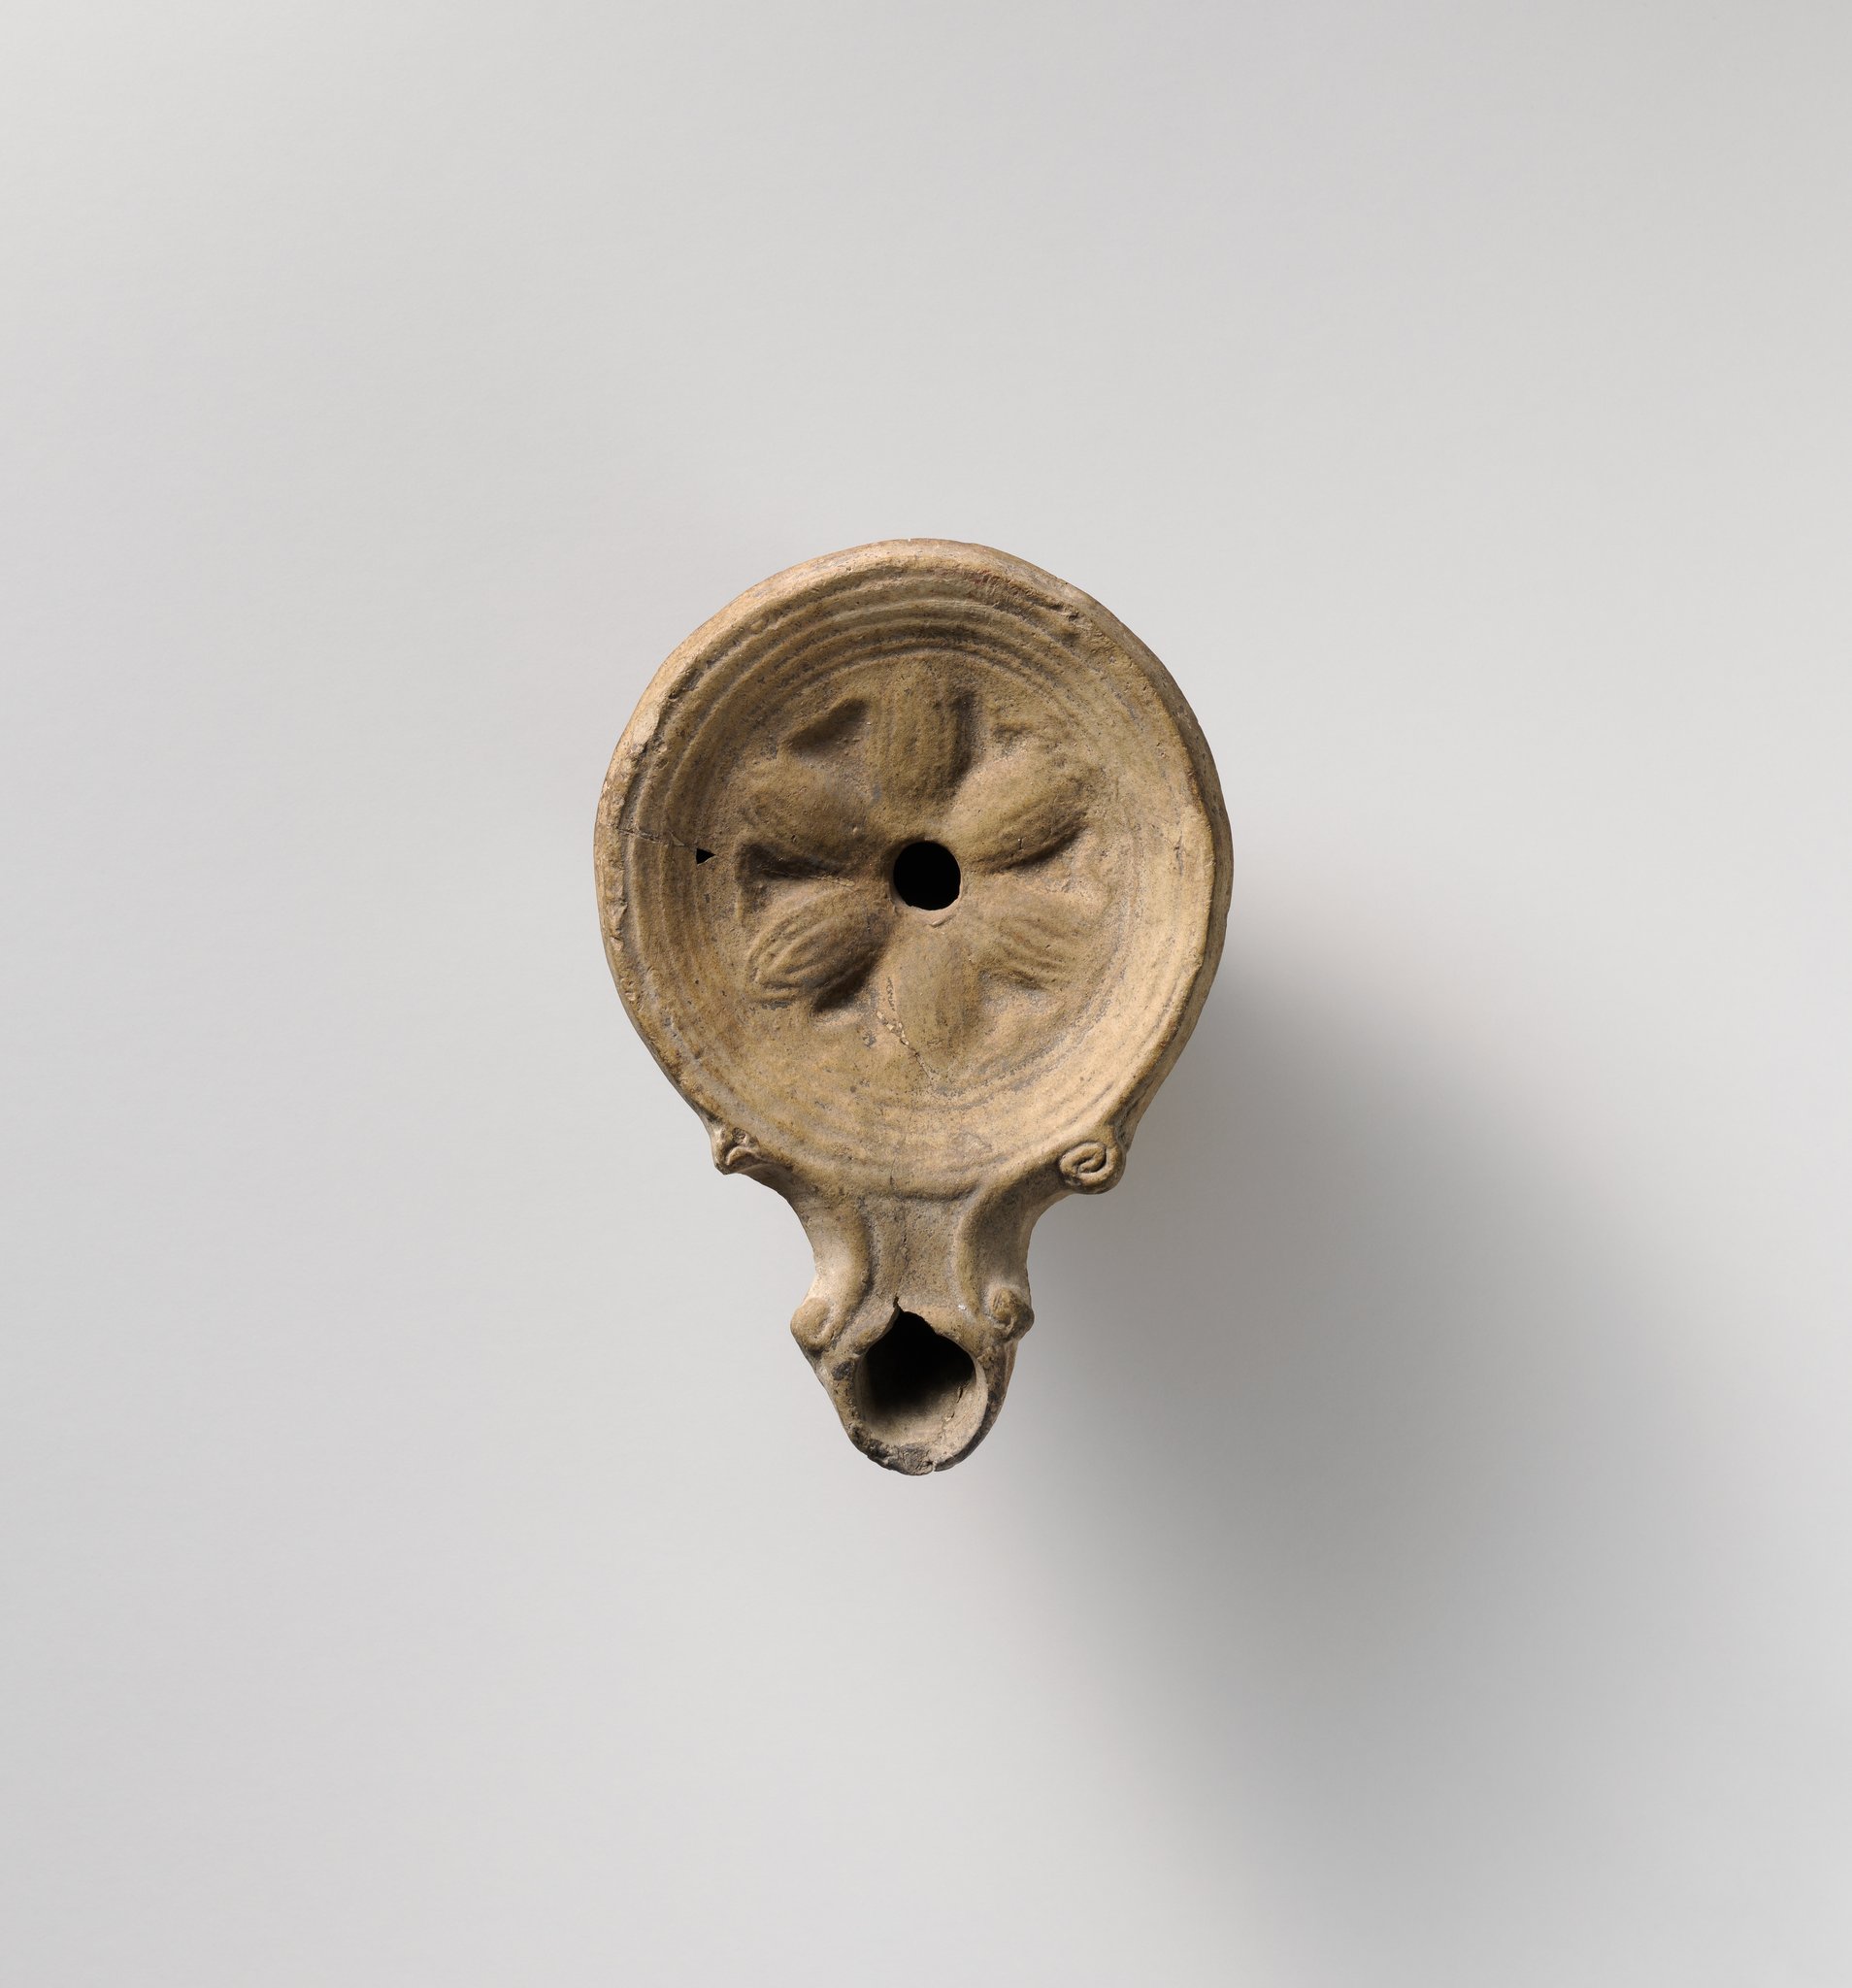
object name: lamp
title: Terracotta oil lamp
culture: roman, cypriot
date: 1-33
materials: terracotta